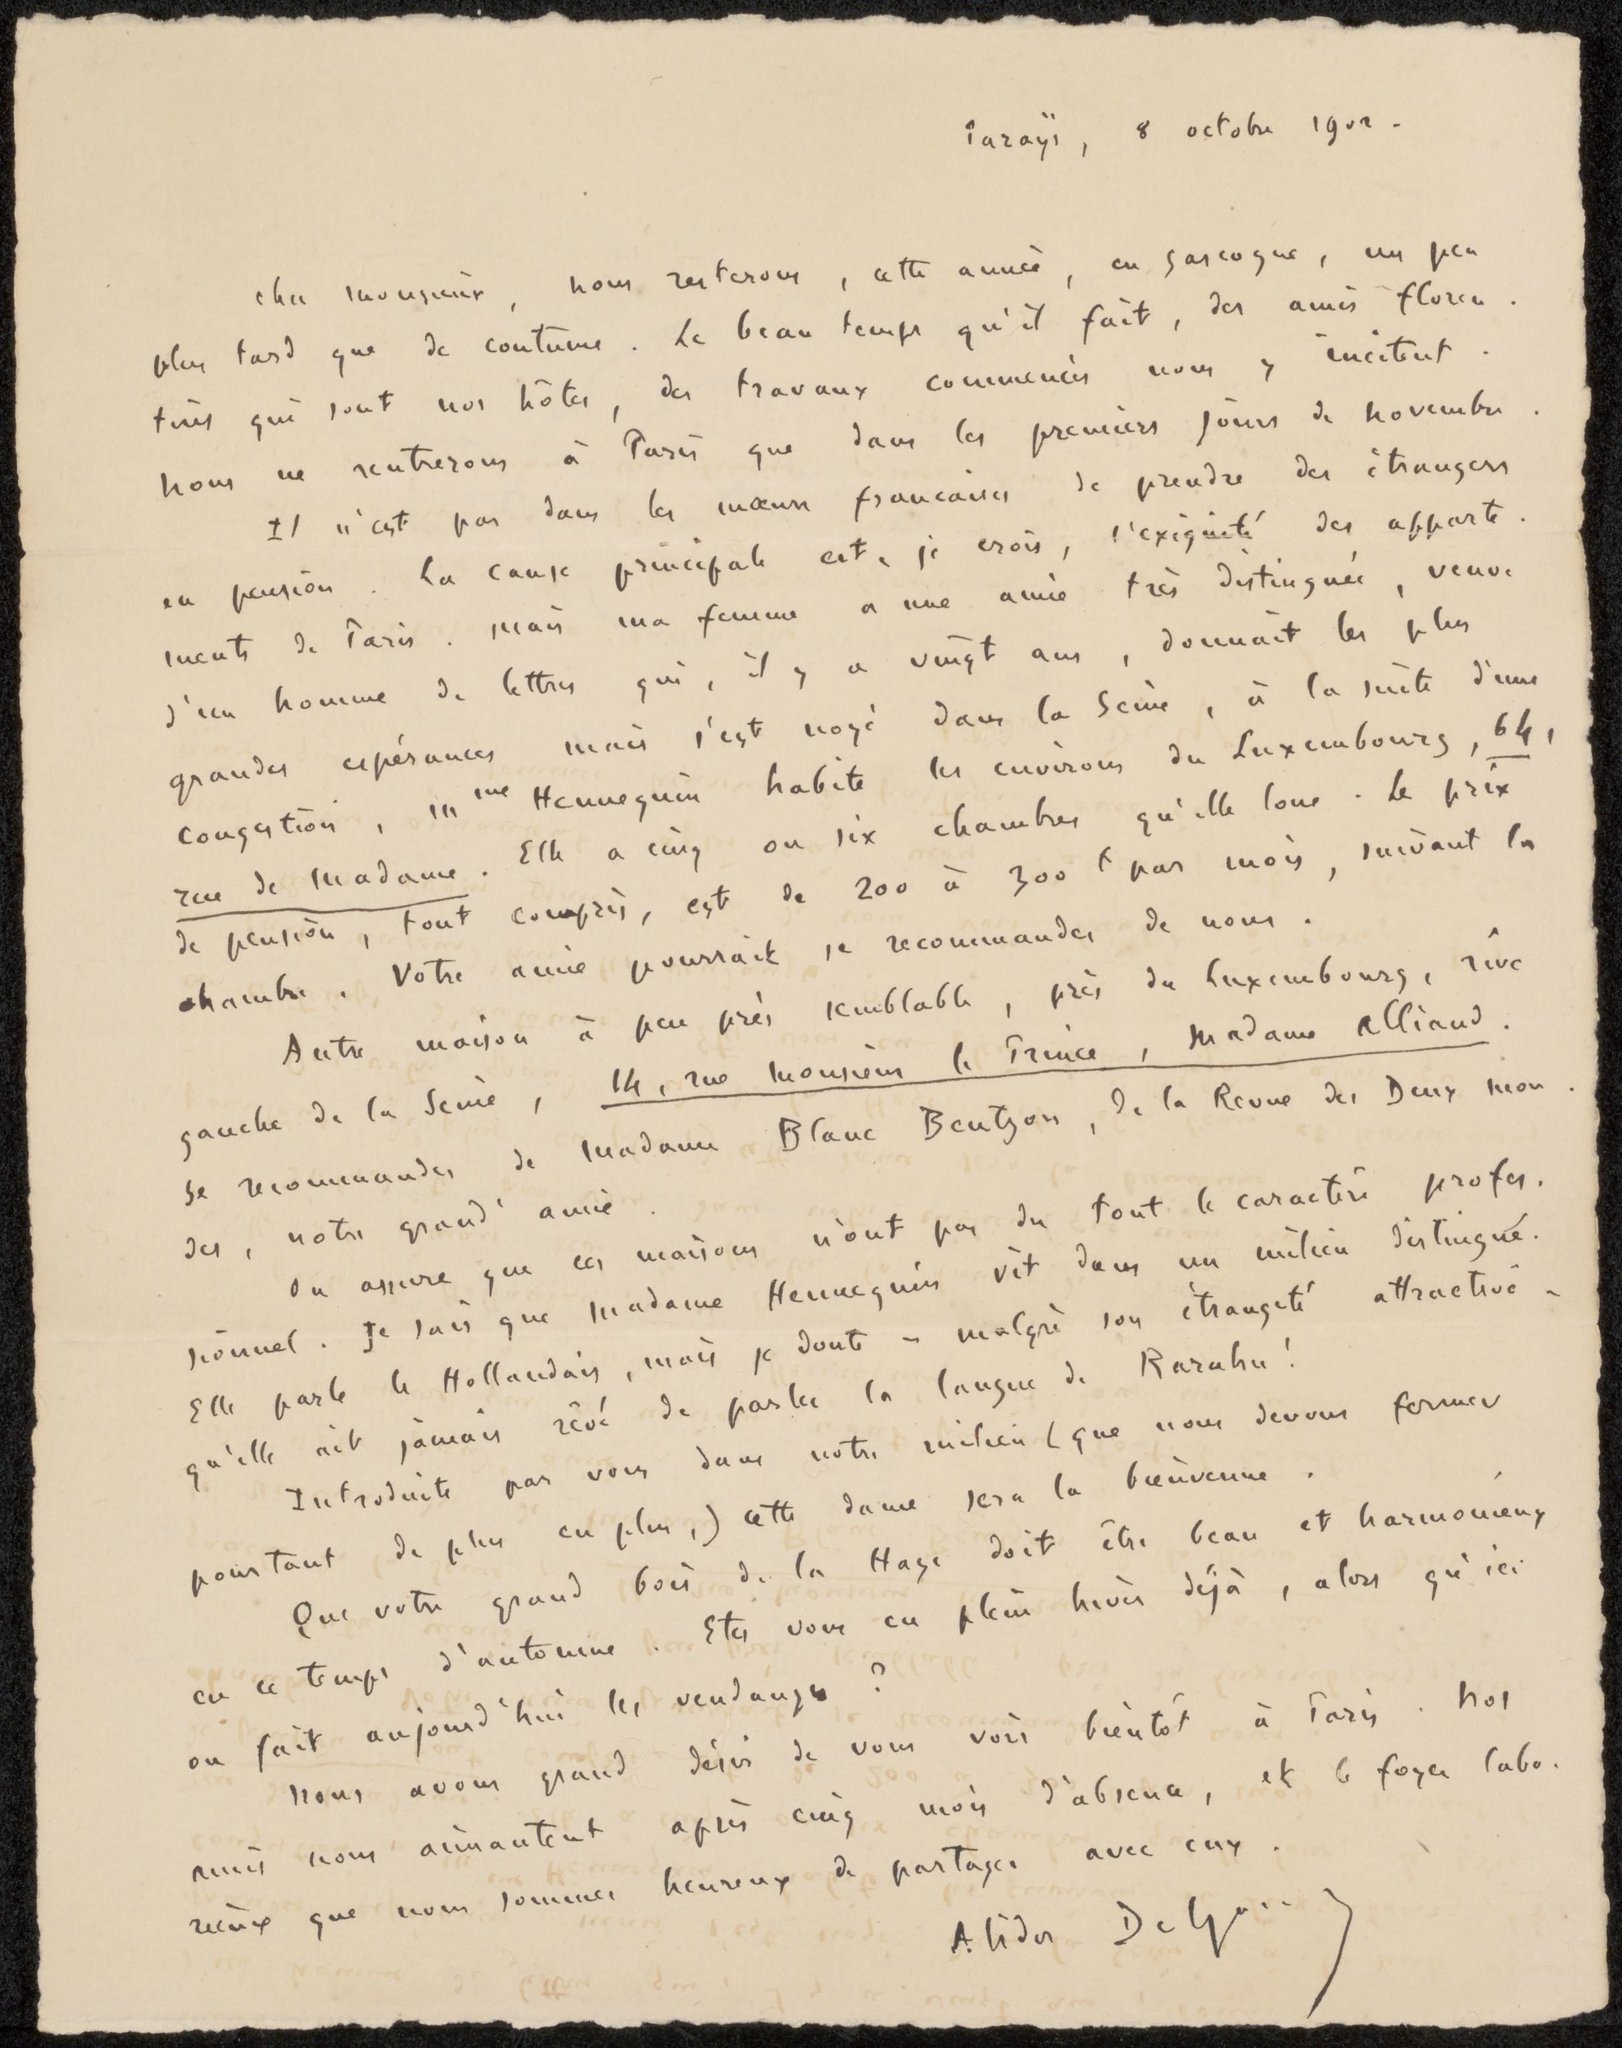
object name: letter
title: Brief aan Philip Zilcken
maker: alidor delzant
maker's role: advocaat, auteur, kunstverzamelaar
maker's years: 1848-1905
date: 1902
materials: ink, paper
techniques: pen, writing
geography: parays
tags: the hague, painter, draughtsman, philip zilcken, paris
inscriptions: collector's mark: ‘RPK’, watermark